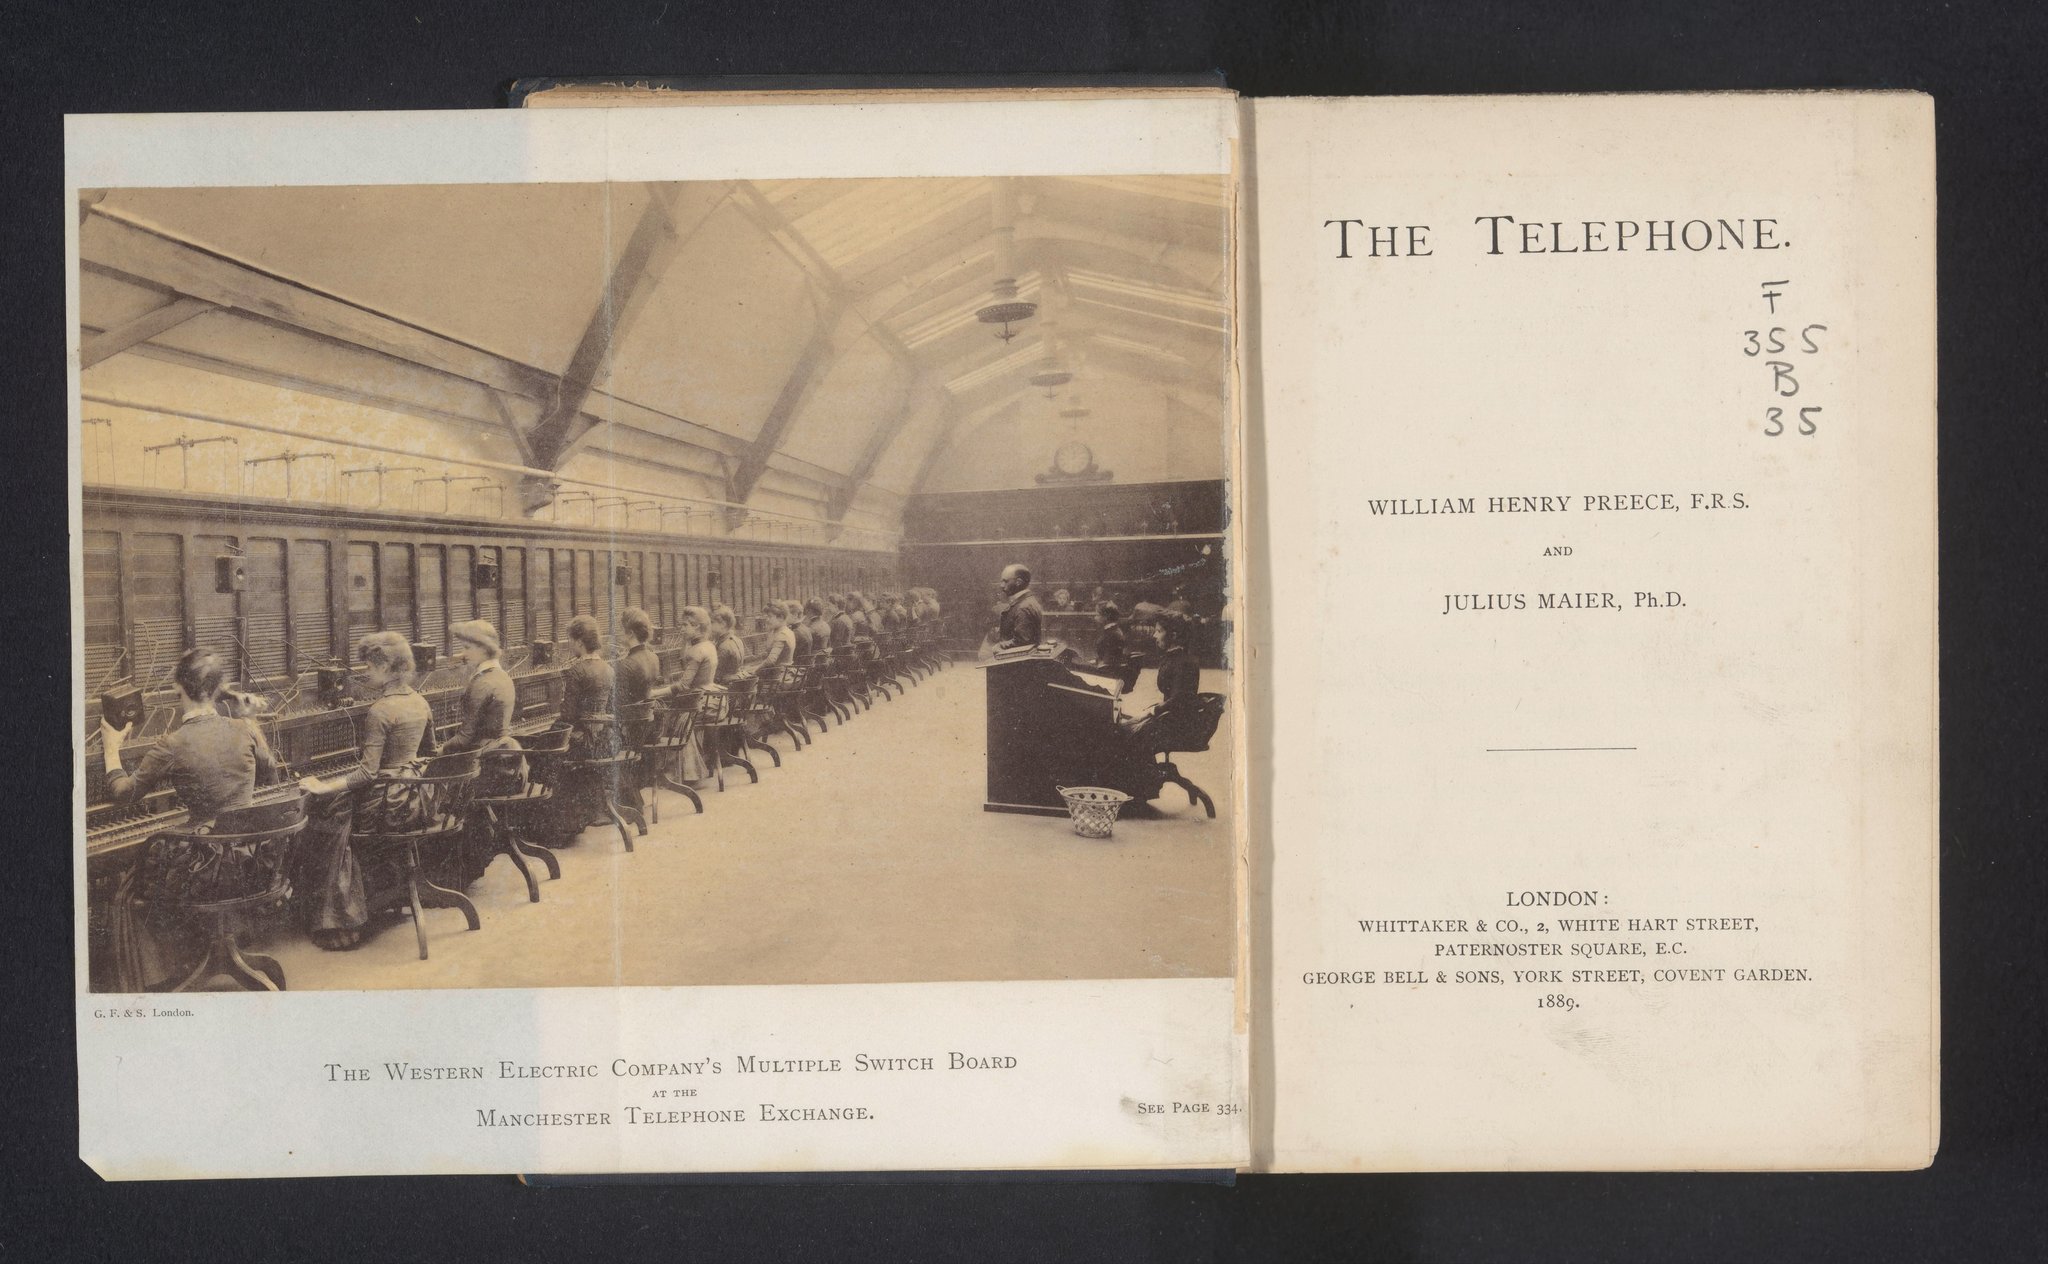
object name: book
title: The telephone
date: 1889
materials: cardboard, linen, paper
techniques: photograph, printing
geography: london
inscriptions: inscription: ‘"The electrician" Printing and Publishing Co., Limited. Salisbury Court, Fleet St., London, E.C.’